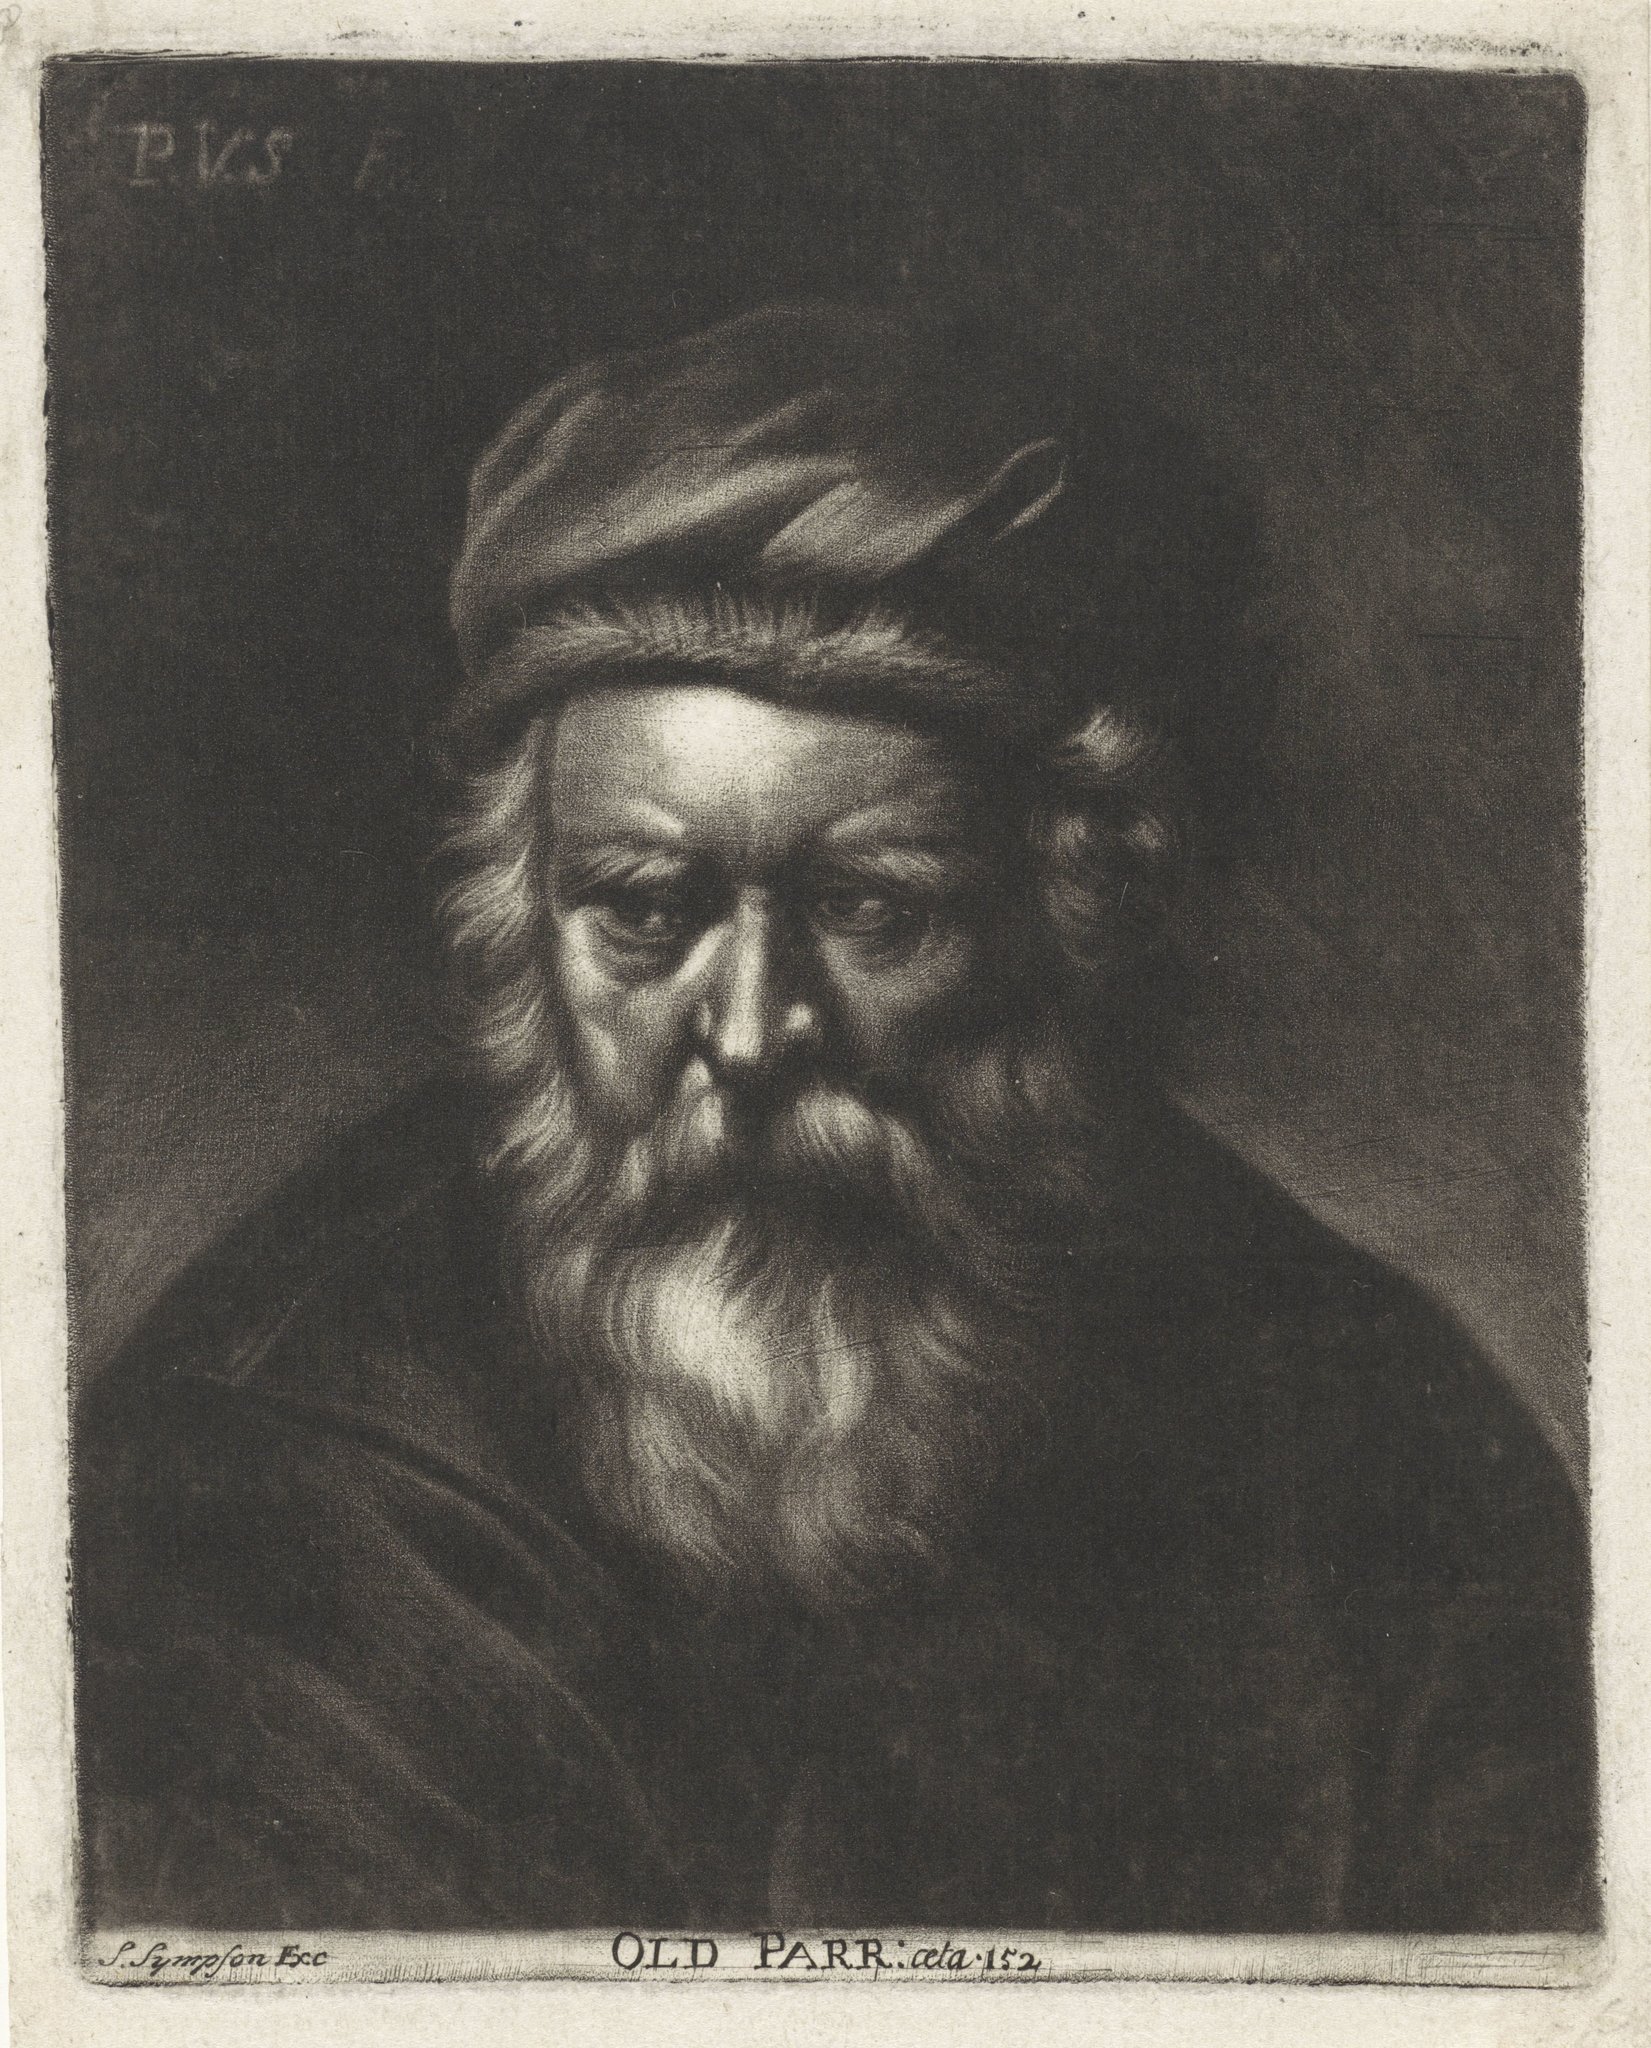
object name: print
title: Old Parr: aeta 152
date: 1659-1704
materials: paper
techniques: mezzotint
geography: paris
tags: london, head-gear: cap (+ men's clothes)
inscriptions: collector's mark: Lugt 2760, collector's mark: Lugt 2228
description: Thomas Parr op 152-jarige leeftijd. Hij draagt een muts.